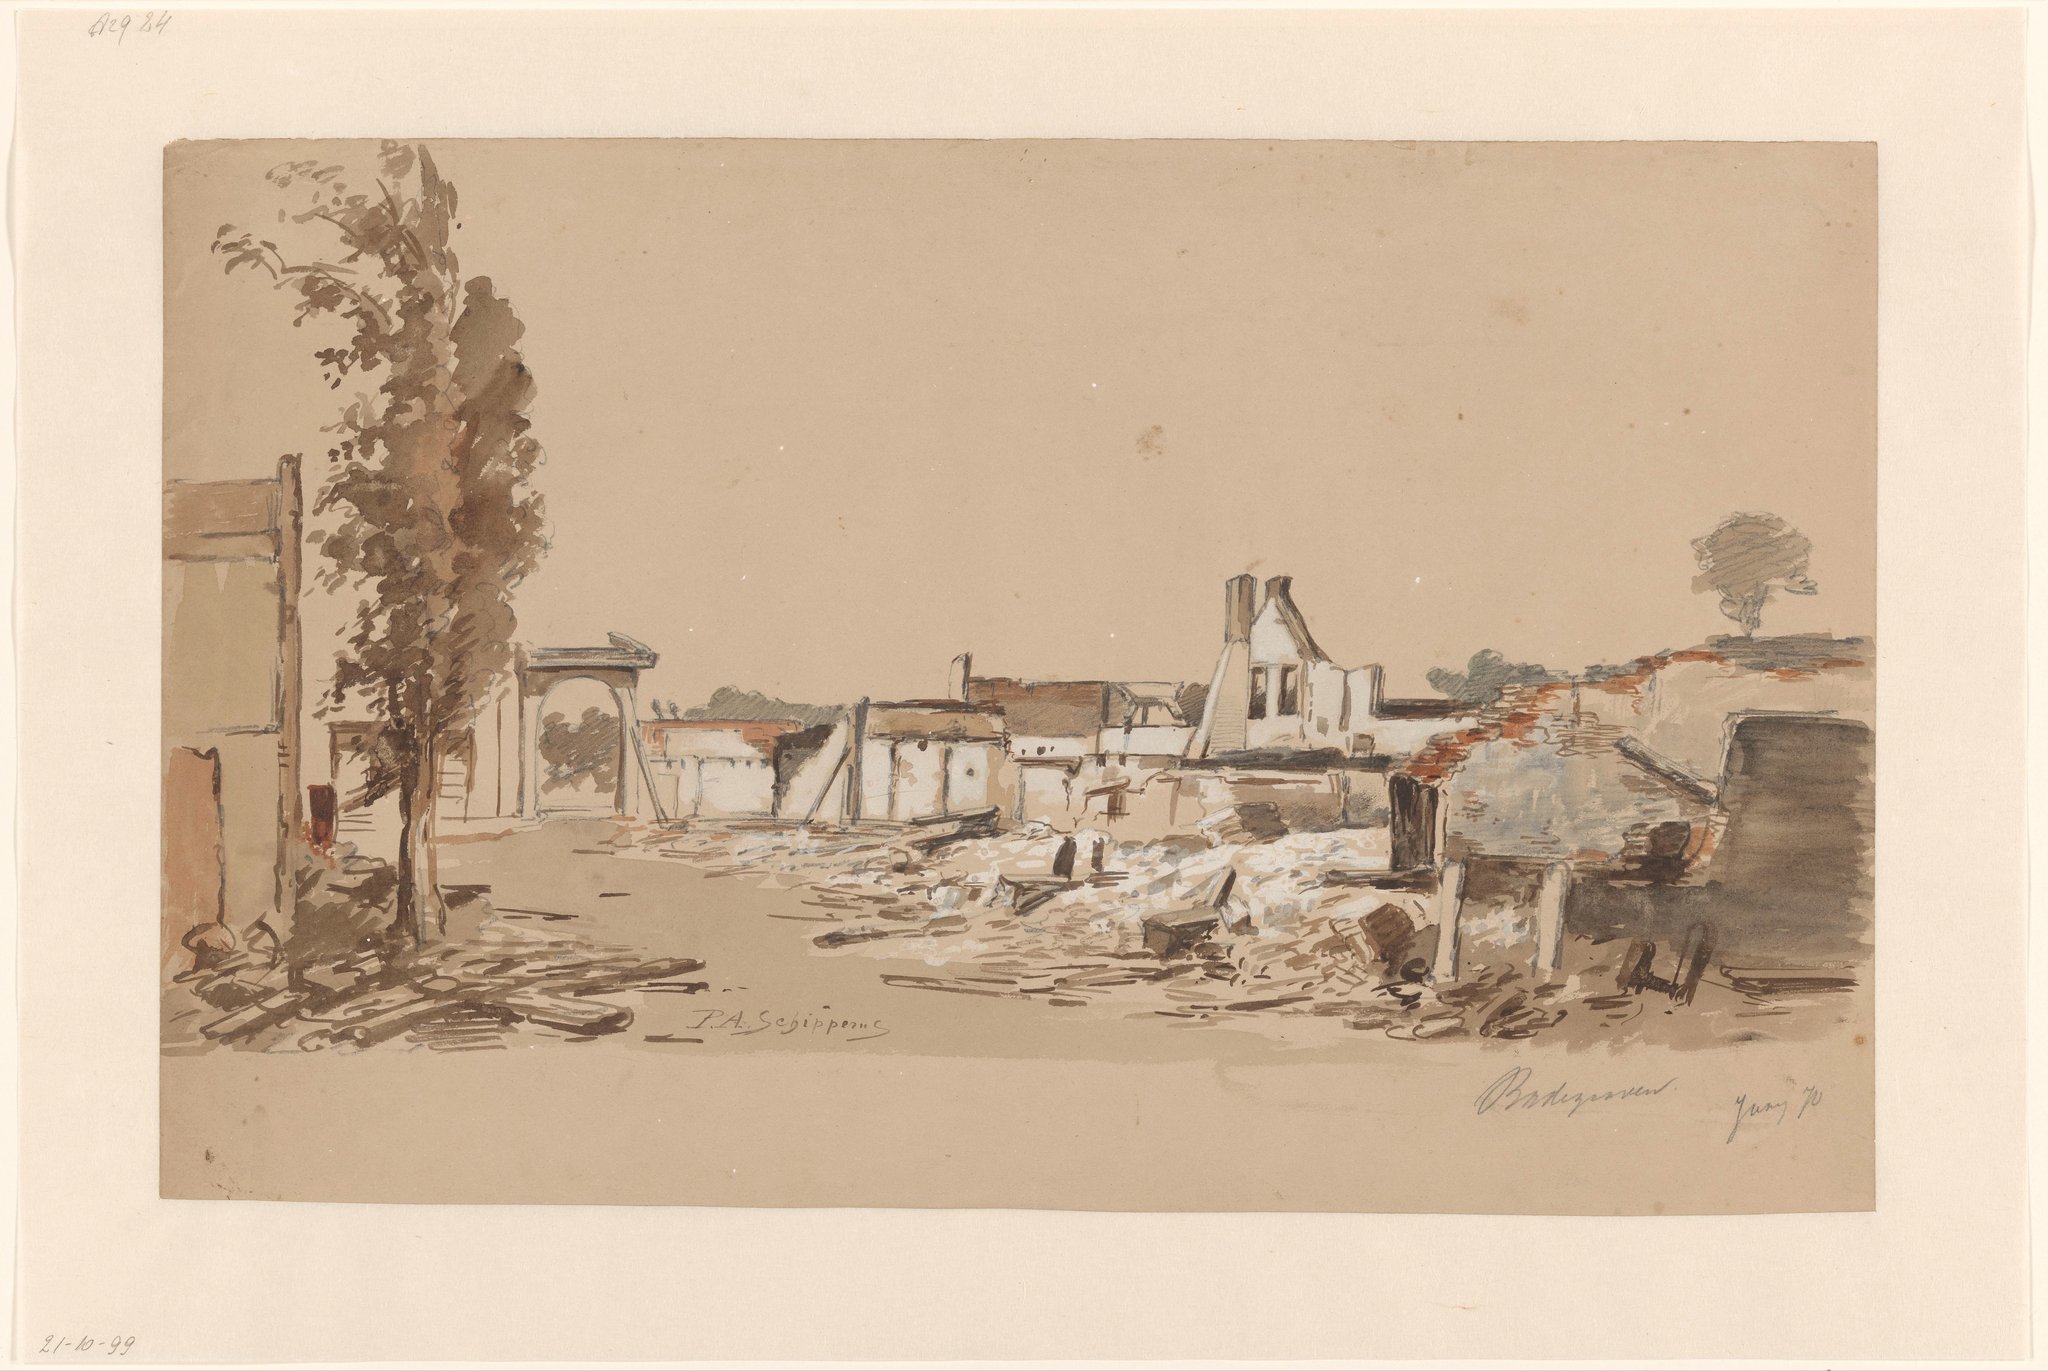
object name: drawing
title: Ruïnes van Bodegraven na de brand van 31 mei 1870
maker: piet schipperus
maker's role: draughtsman, print maker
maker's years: 1840-1929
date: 1850-1894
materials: paper, pencil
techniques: brush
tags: on fire, ablaze, ruin of a building ~ architecture, historical events and situations, bodegraven